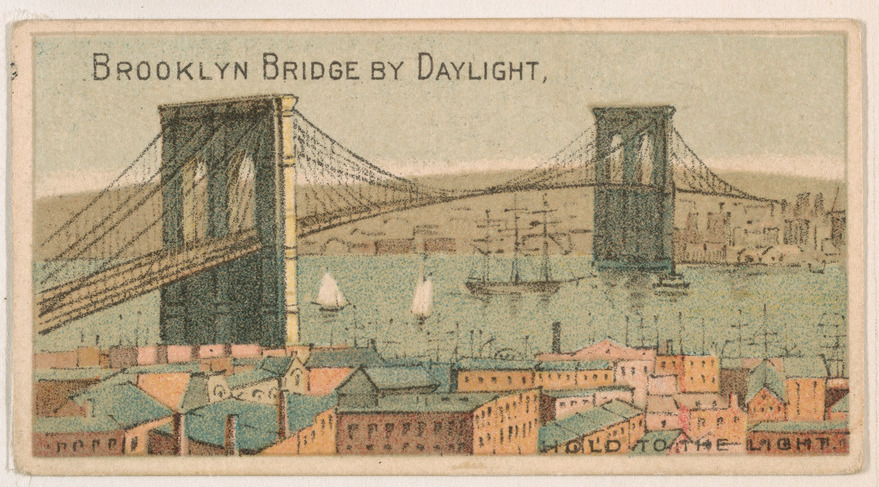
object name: print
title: Brooklyn Bridge By Daylight, from the Magic Changing Cards series (N223) issued by Kinney Tobacco Company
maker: kinney brothers tobacco company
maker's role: publisher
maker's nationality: american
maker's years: 1869-2011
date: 1889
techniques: color lithograph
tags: bridges